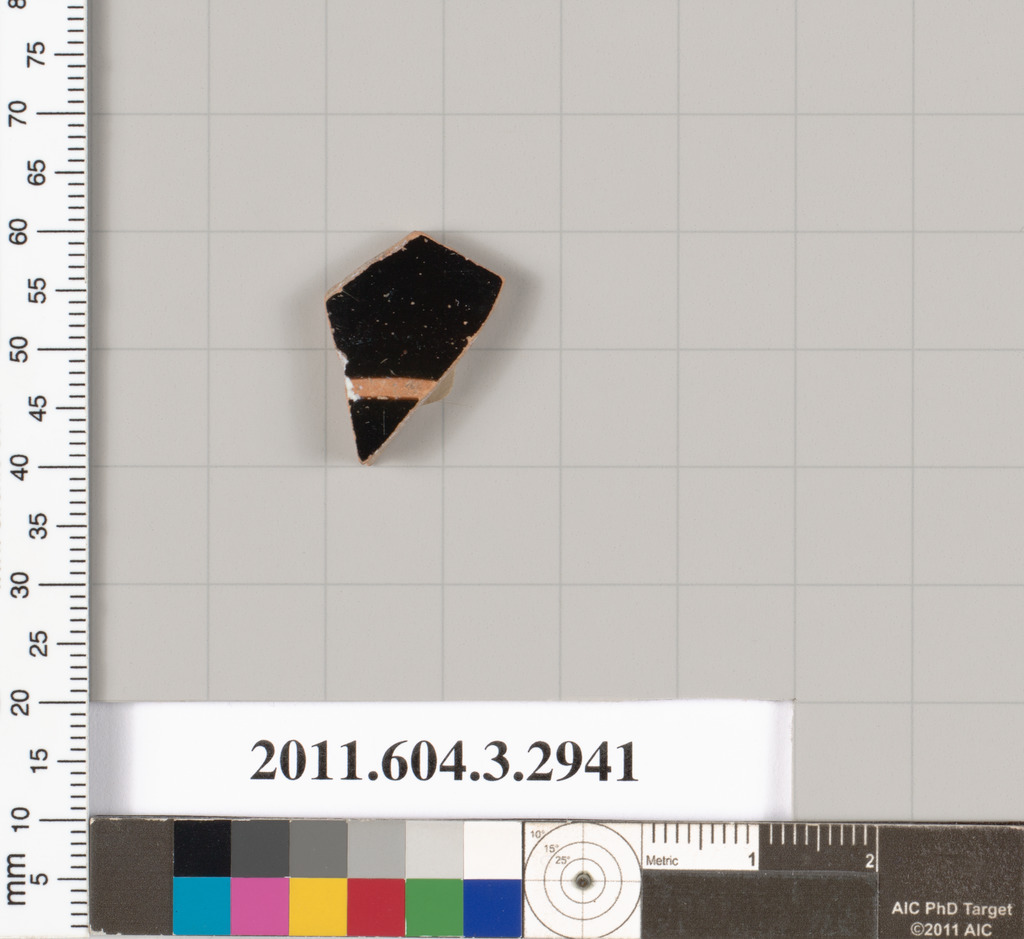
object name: kylix fragment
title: Terracotta fragment of a kylix (drinking cup)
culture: greek, attic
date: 600-401 BCE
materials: terracotta